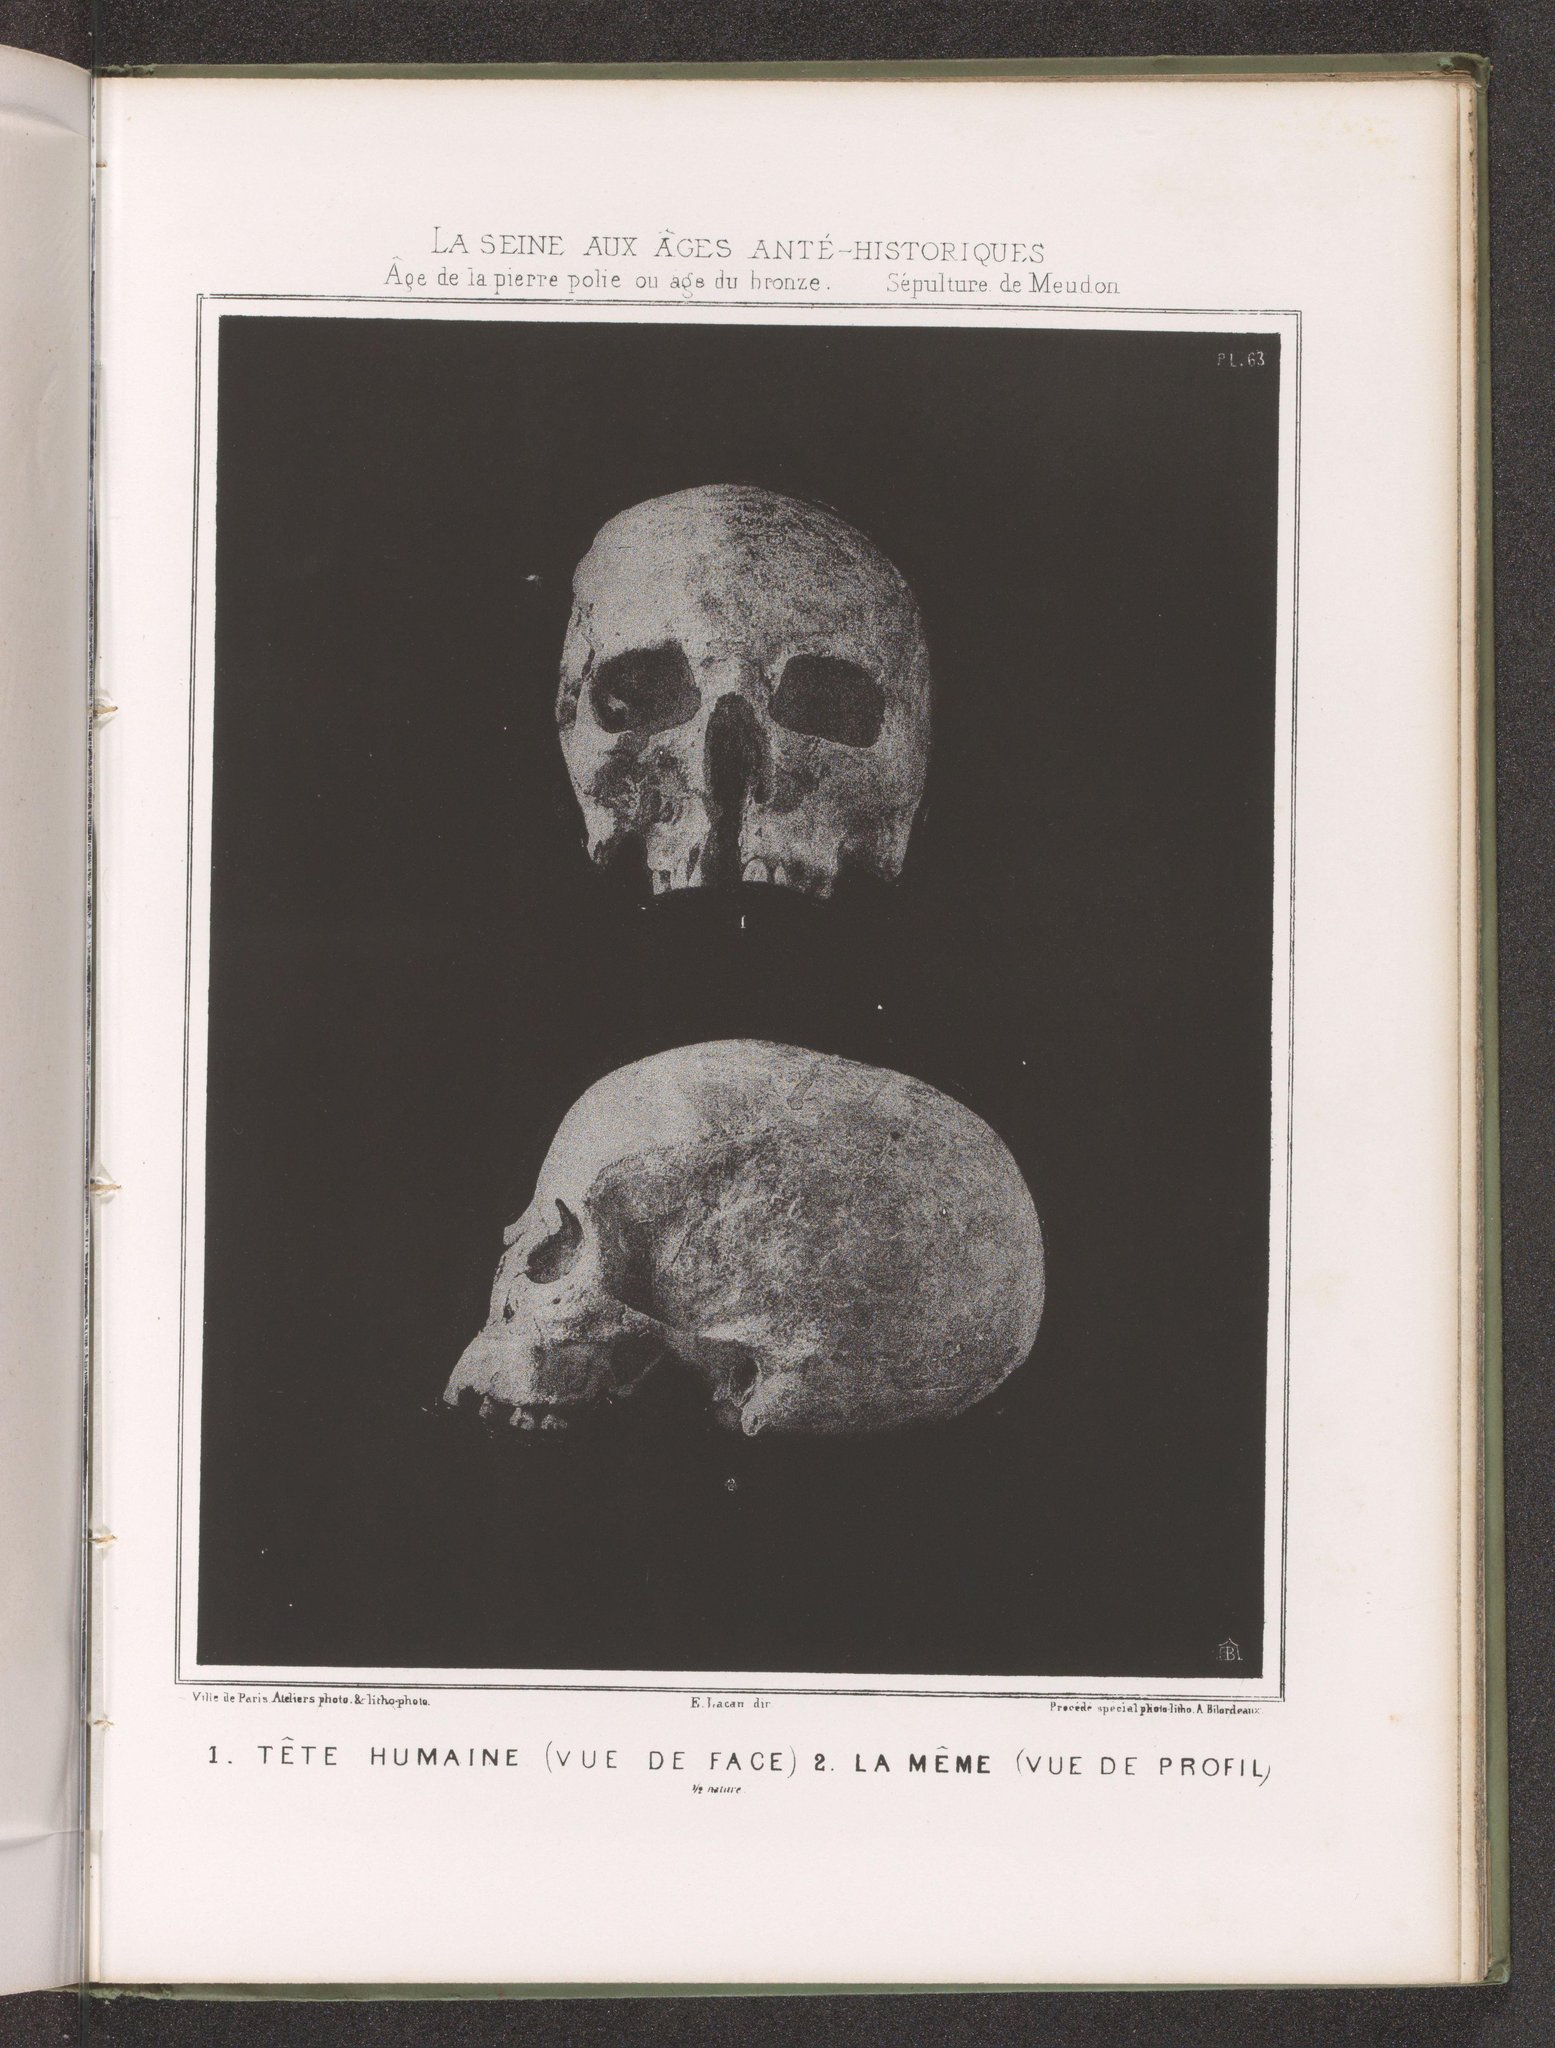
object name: page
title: 1. TÊTE HUMAINE (VUE DE FACE). 2. LA MÊME (VUE DE PROFIL) 1/2 nature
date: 1860-1869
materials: paper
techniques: photolithography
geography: paris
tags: animals (+ skeleton of an animal), palaeontology, france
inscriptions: inscription: ‘Ville de Paris Ateliers photo. & litho-photo. E. Lacan dir. Procédé spécial photo-litho. A. Bilordeaux.’, monogram: ‘LEL’, number: ‘Pl. 63’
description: Voor plek prent in boek: zie nummer onder 'Opschriften / Merken'.